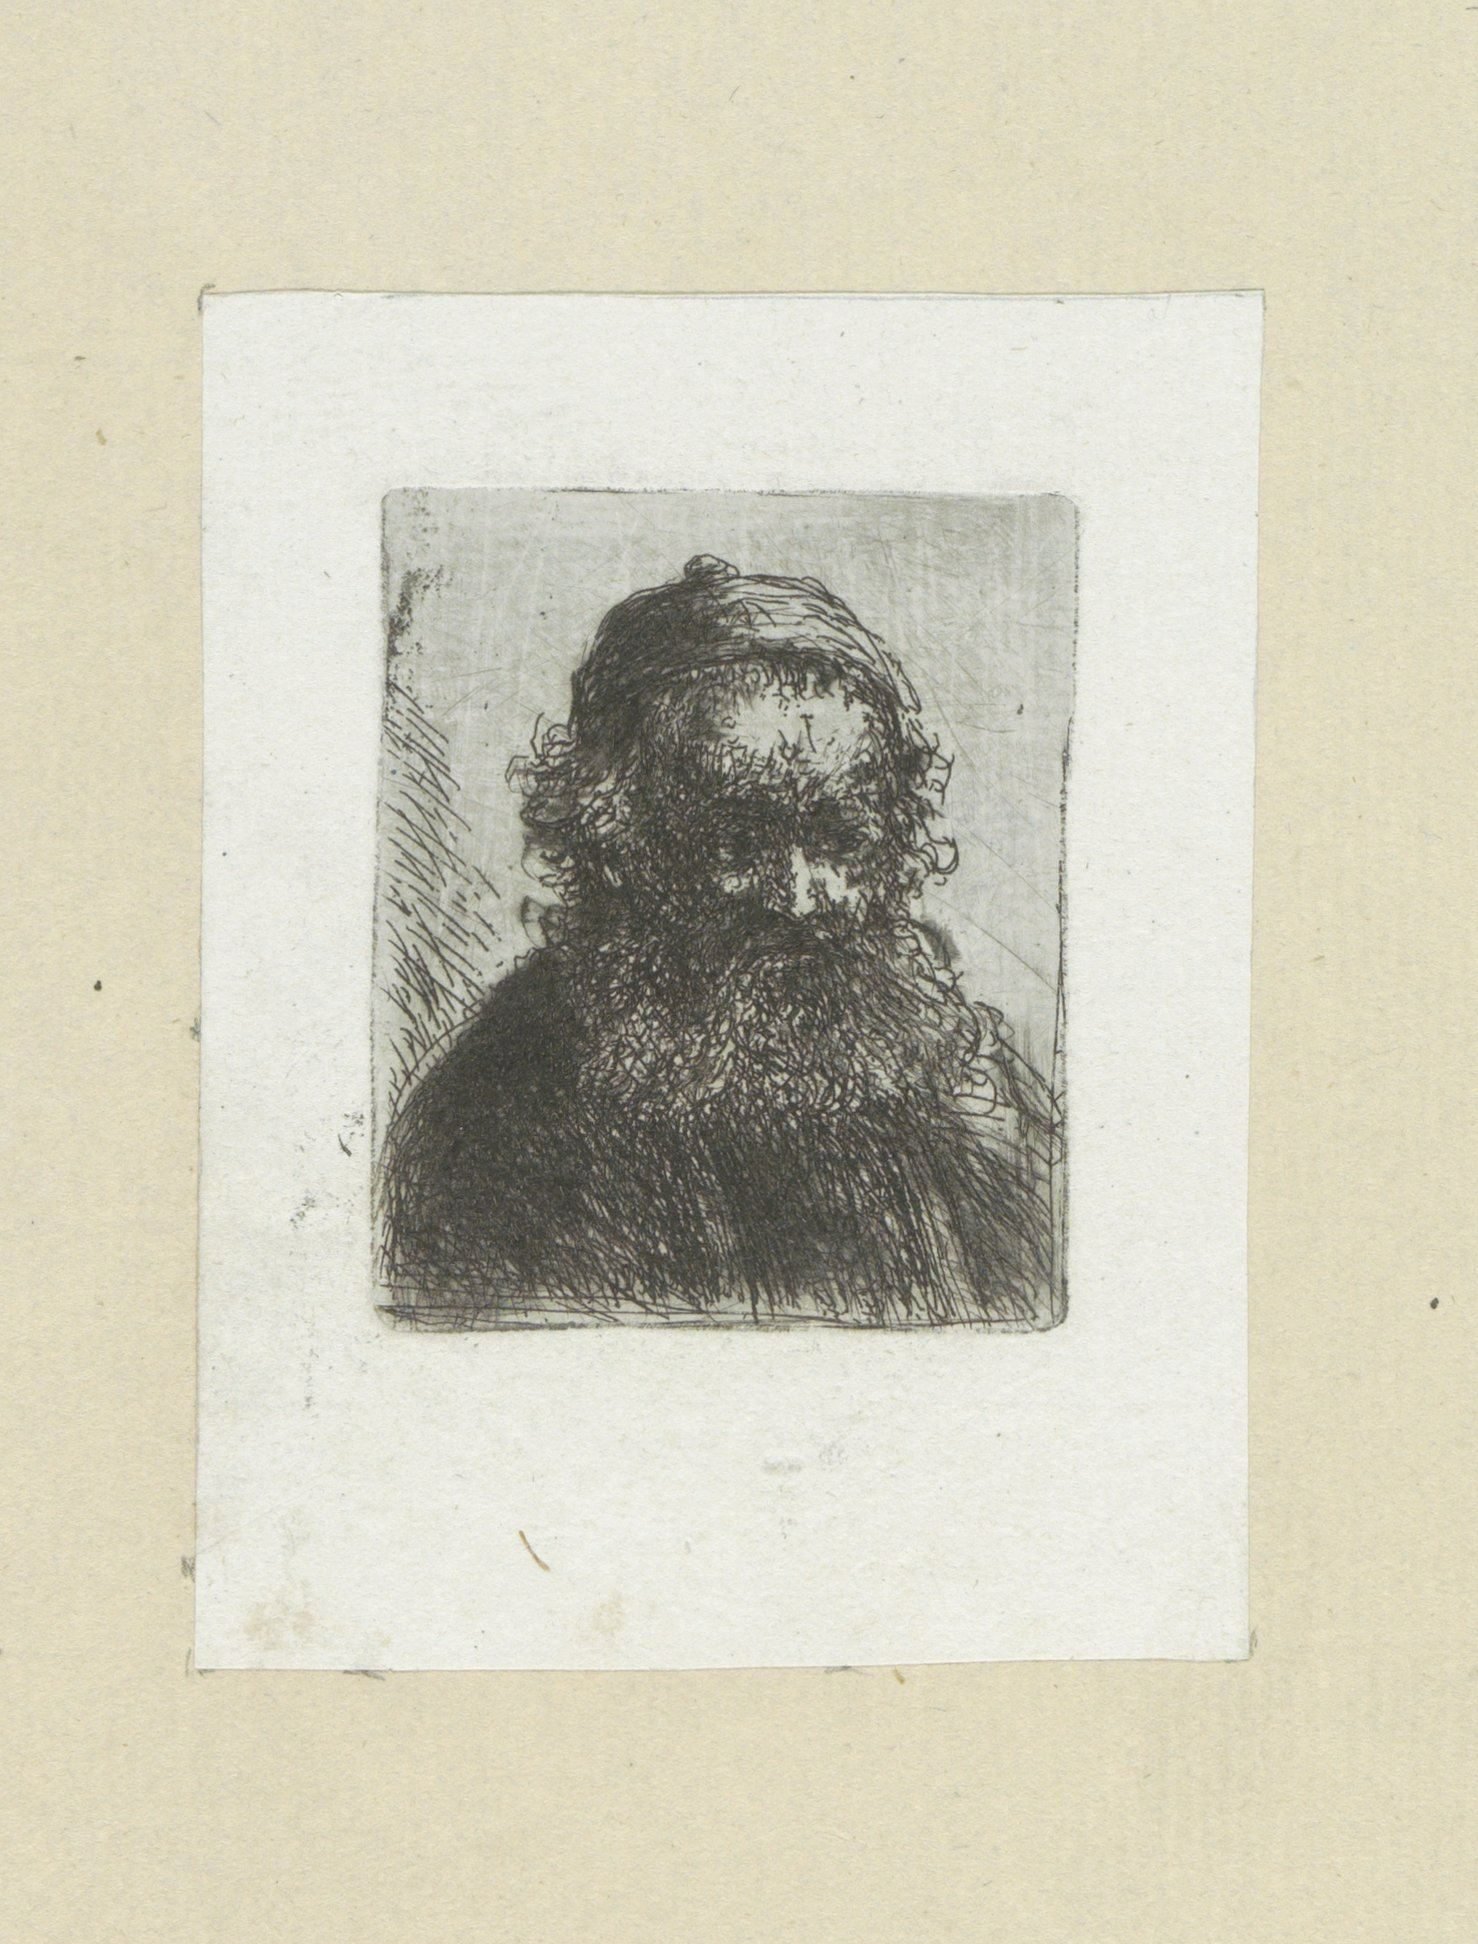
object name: print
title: Oude man met baard en muts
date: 1802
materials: paper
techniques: drypoint, etching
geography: london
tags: morphology of human expression (+ old male (human being))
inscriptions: collector's mark: ‘B’, collector's mark: ‘RIJKS / MUSM’